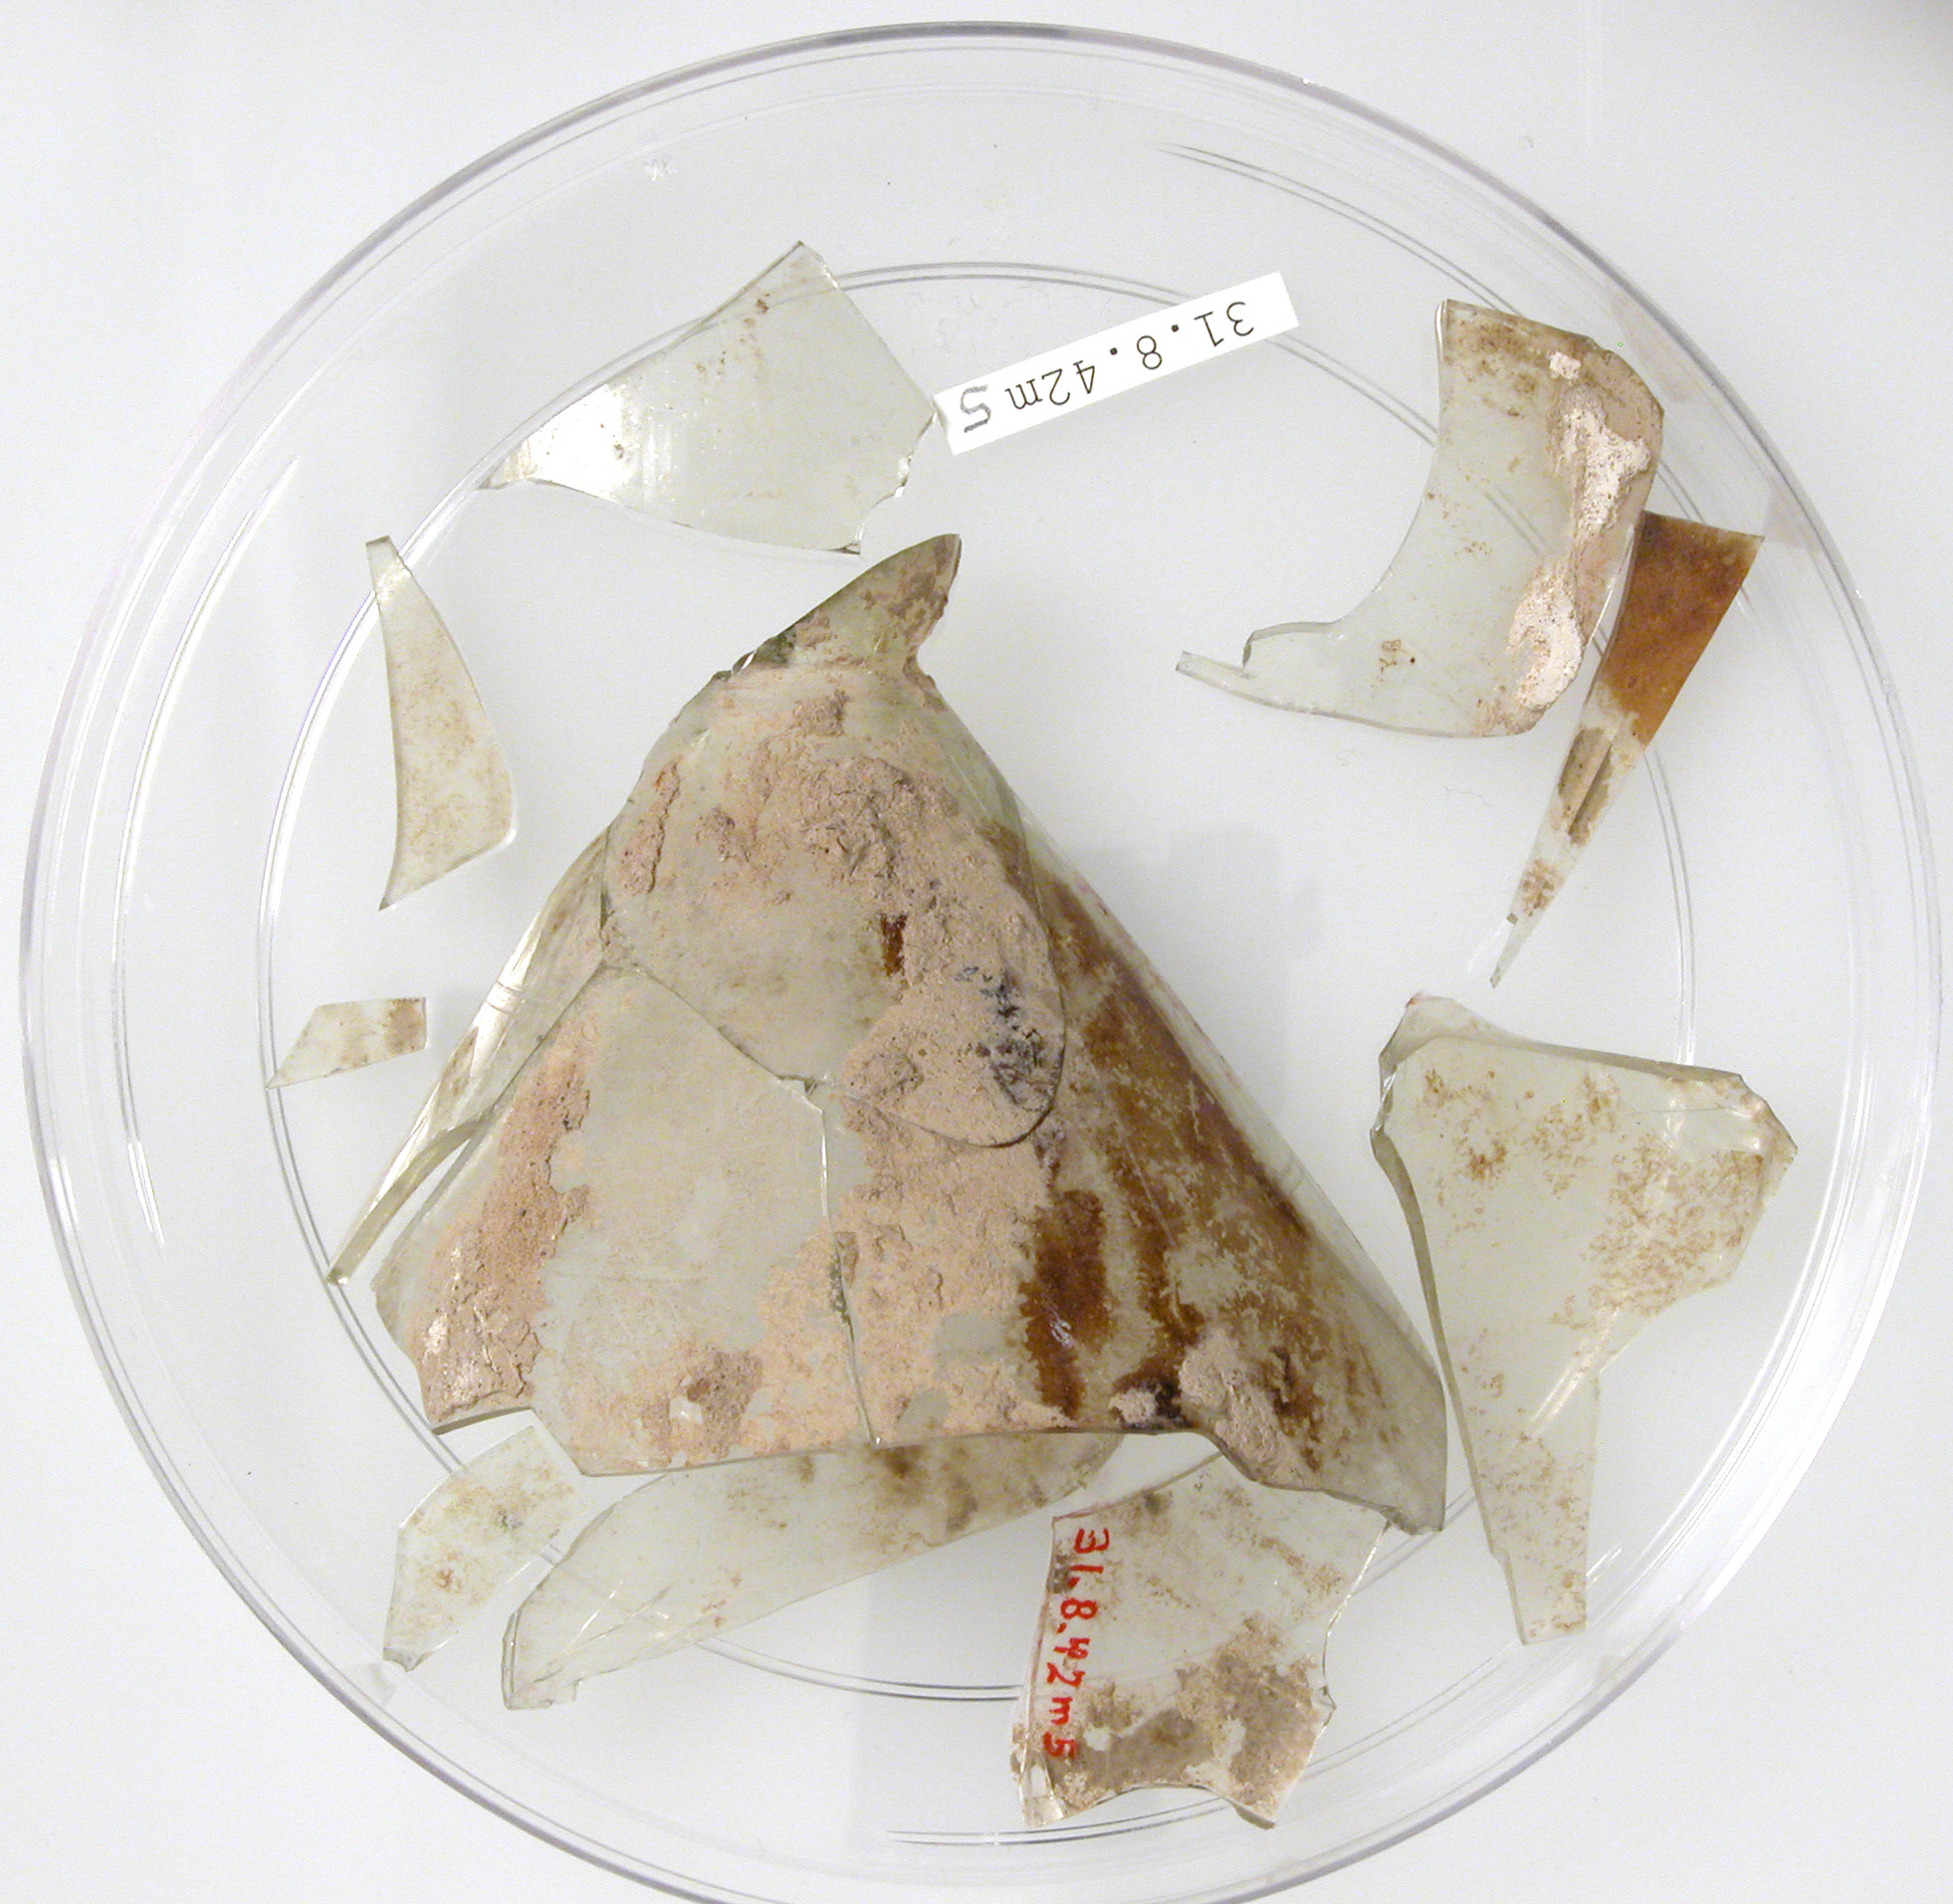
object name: fragment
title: Glass Fragments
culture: coptic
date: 301-400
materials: glass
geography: egypt